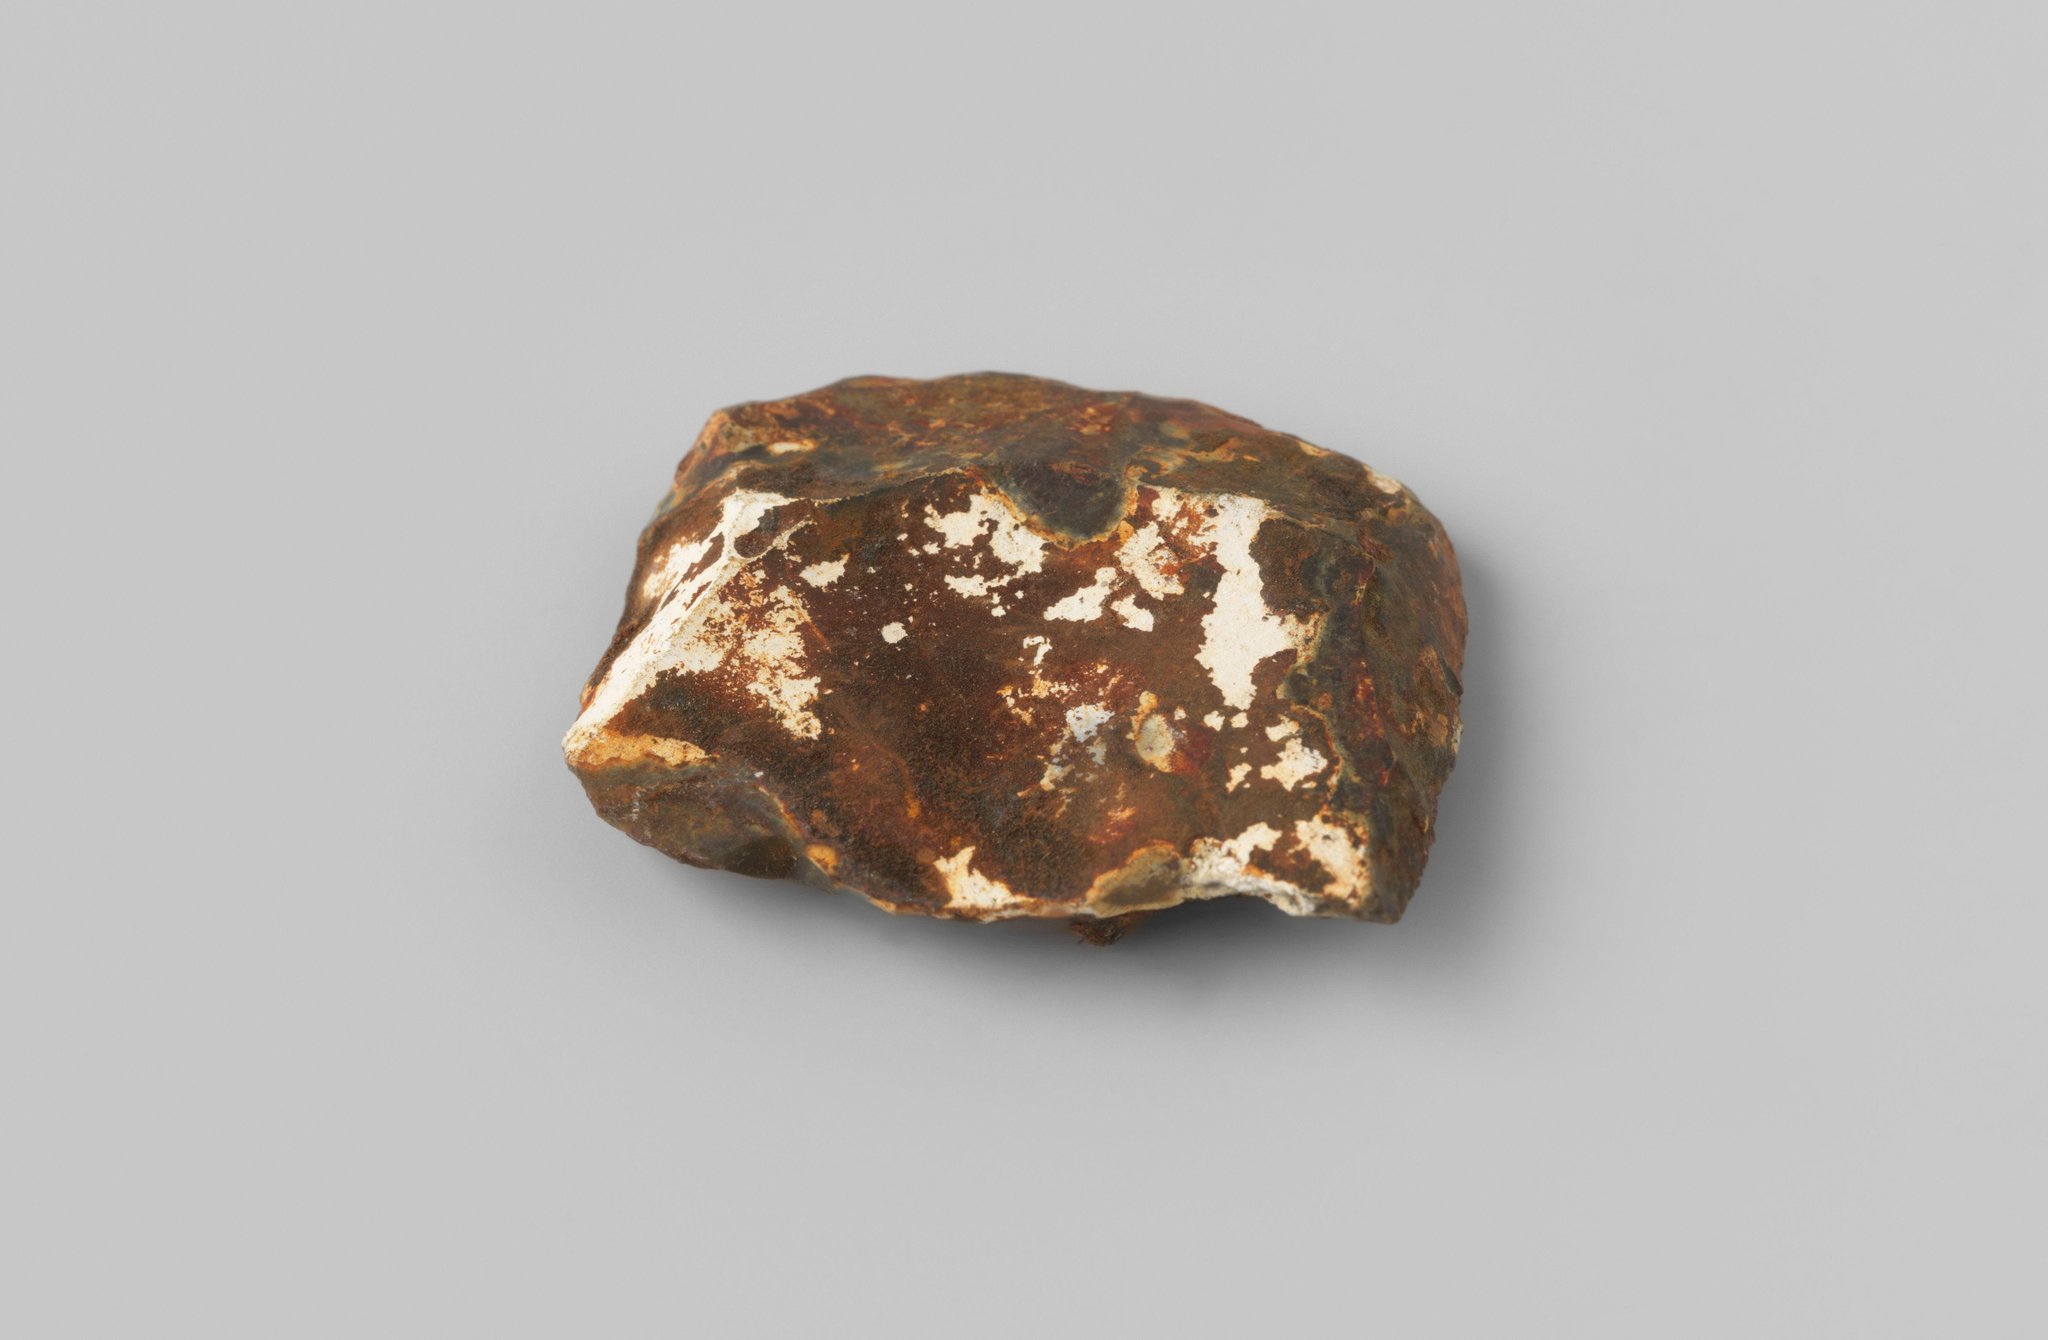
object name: gunflint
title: Vuursteen van een handwapen uit het wrak van de Oost-Indiëvaarder Hollandia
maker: Anonymous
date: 1700-1743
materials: stone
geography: netherlands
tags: verenigde oostindische compagnie, hollandia (schip), annet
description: Hand weapon, flint; sim. NG 1980-27H3128.